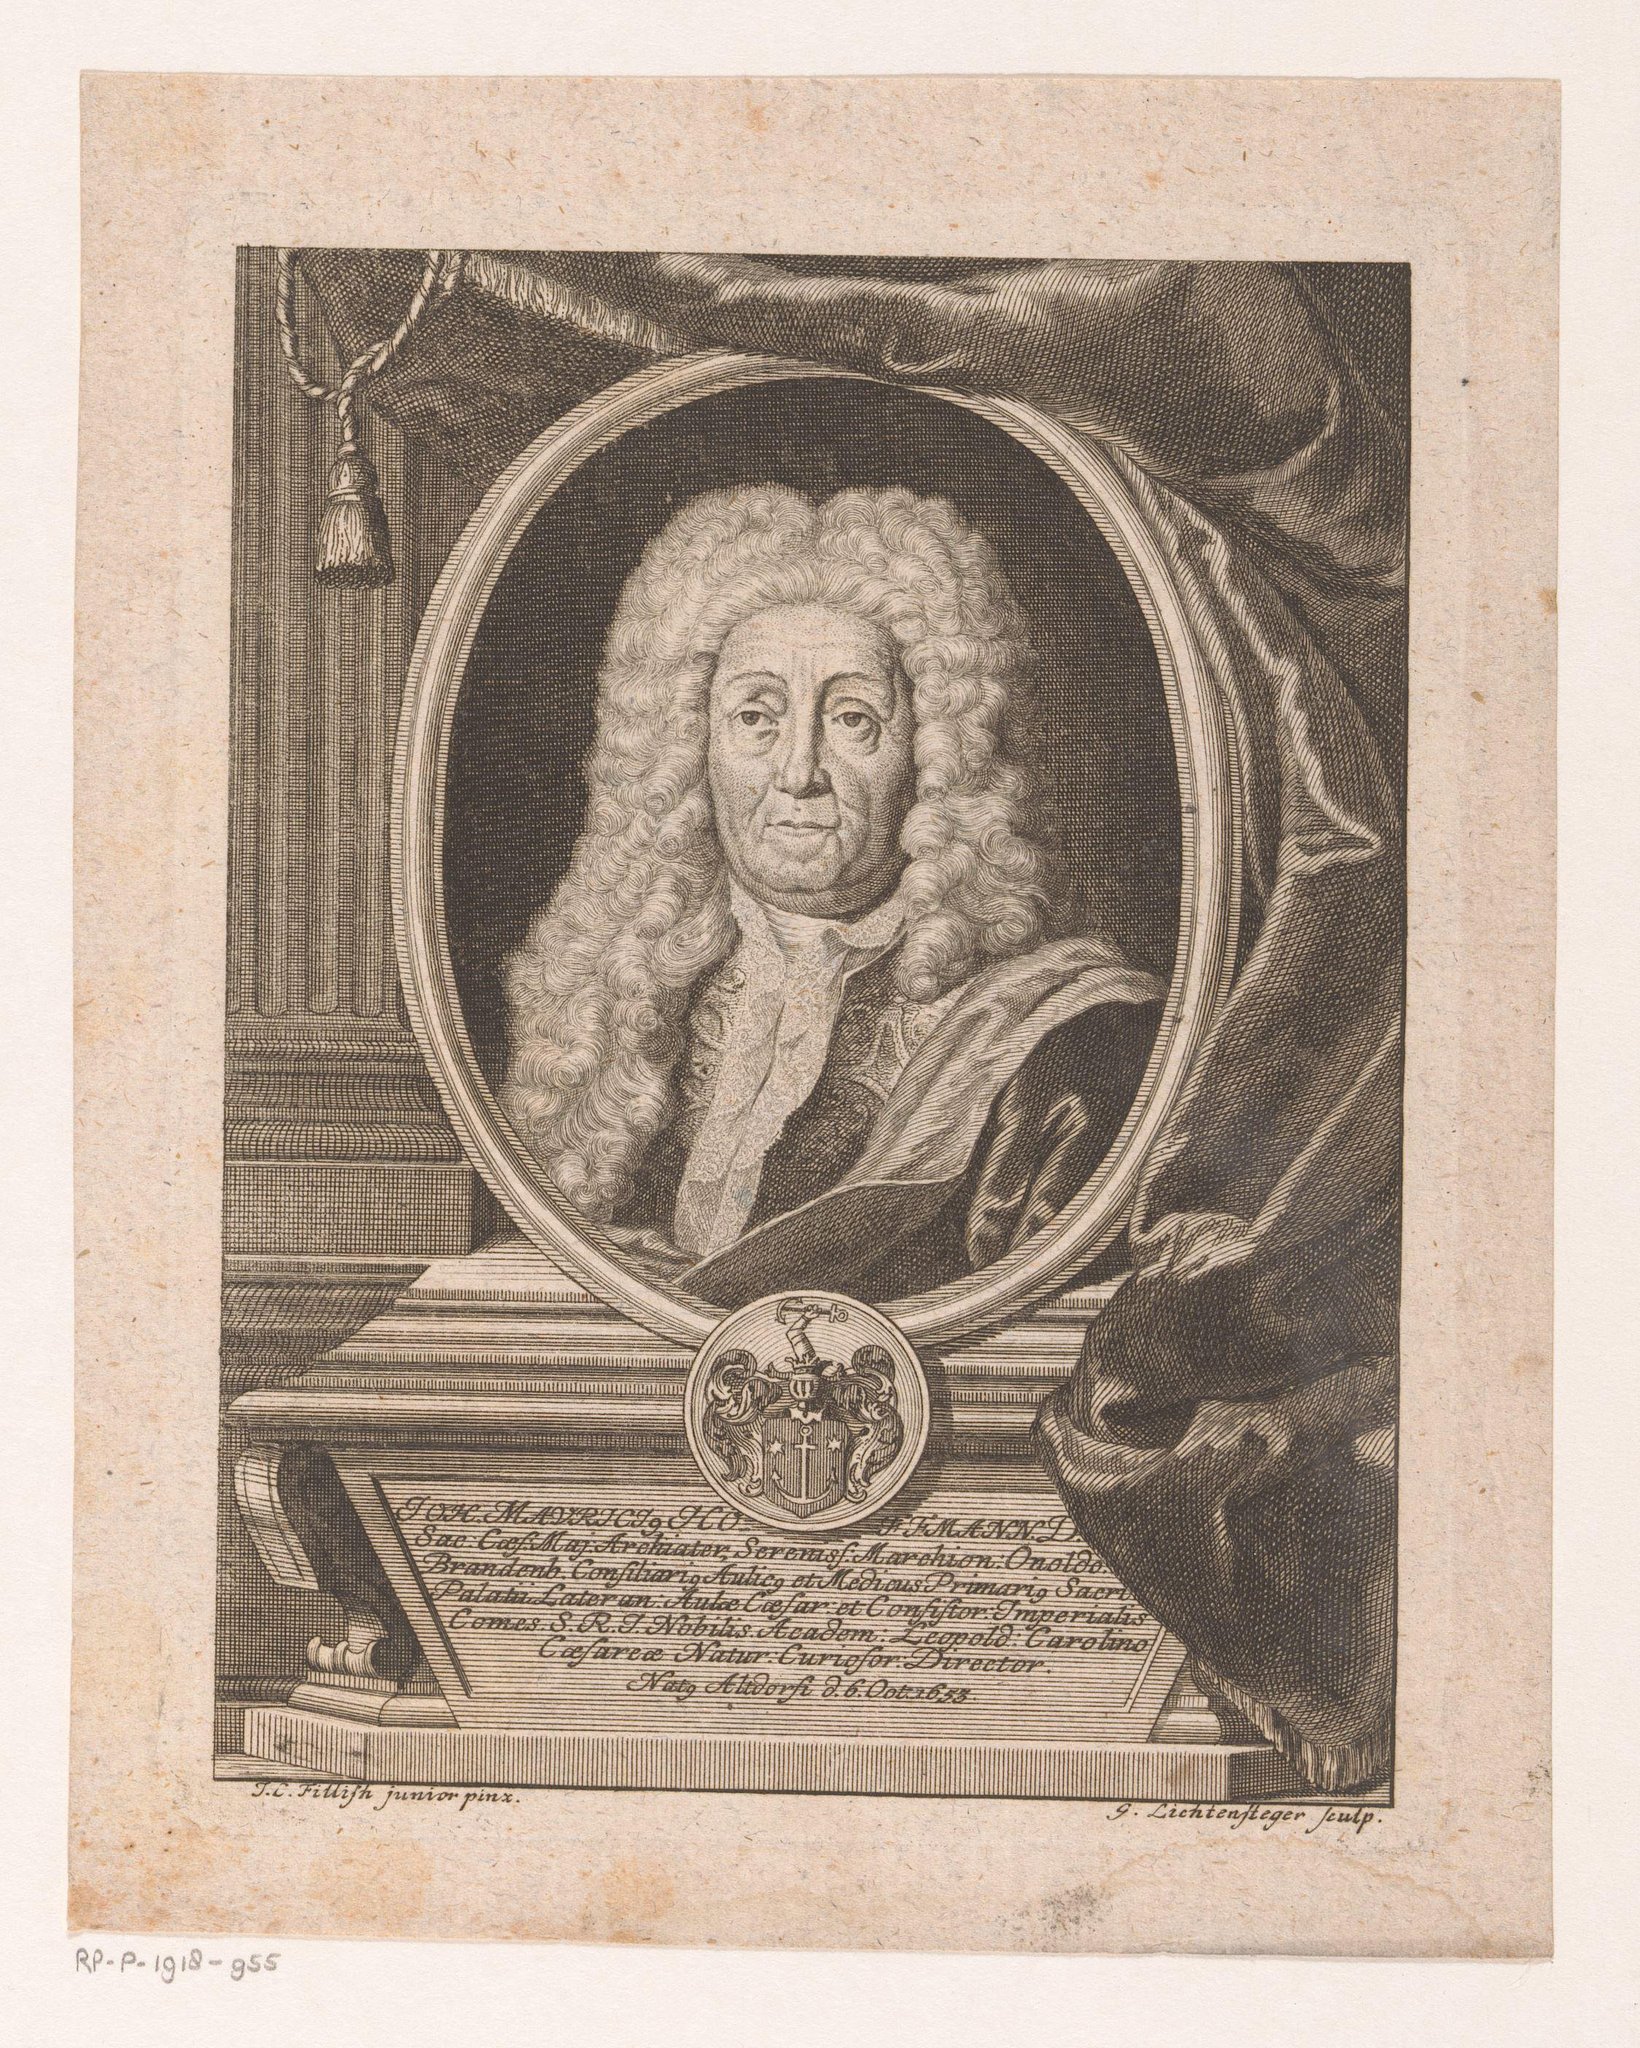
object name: print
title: Portret van Johann Moritz Hoffmann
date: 1710-1781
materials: paper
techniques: engraving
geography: nuremberg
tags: historical persons, armorial bearing, heraldry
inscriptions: collector's mark: Lugt 2233